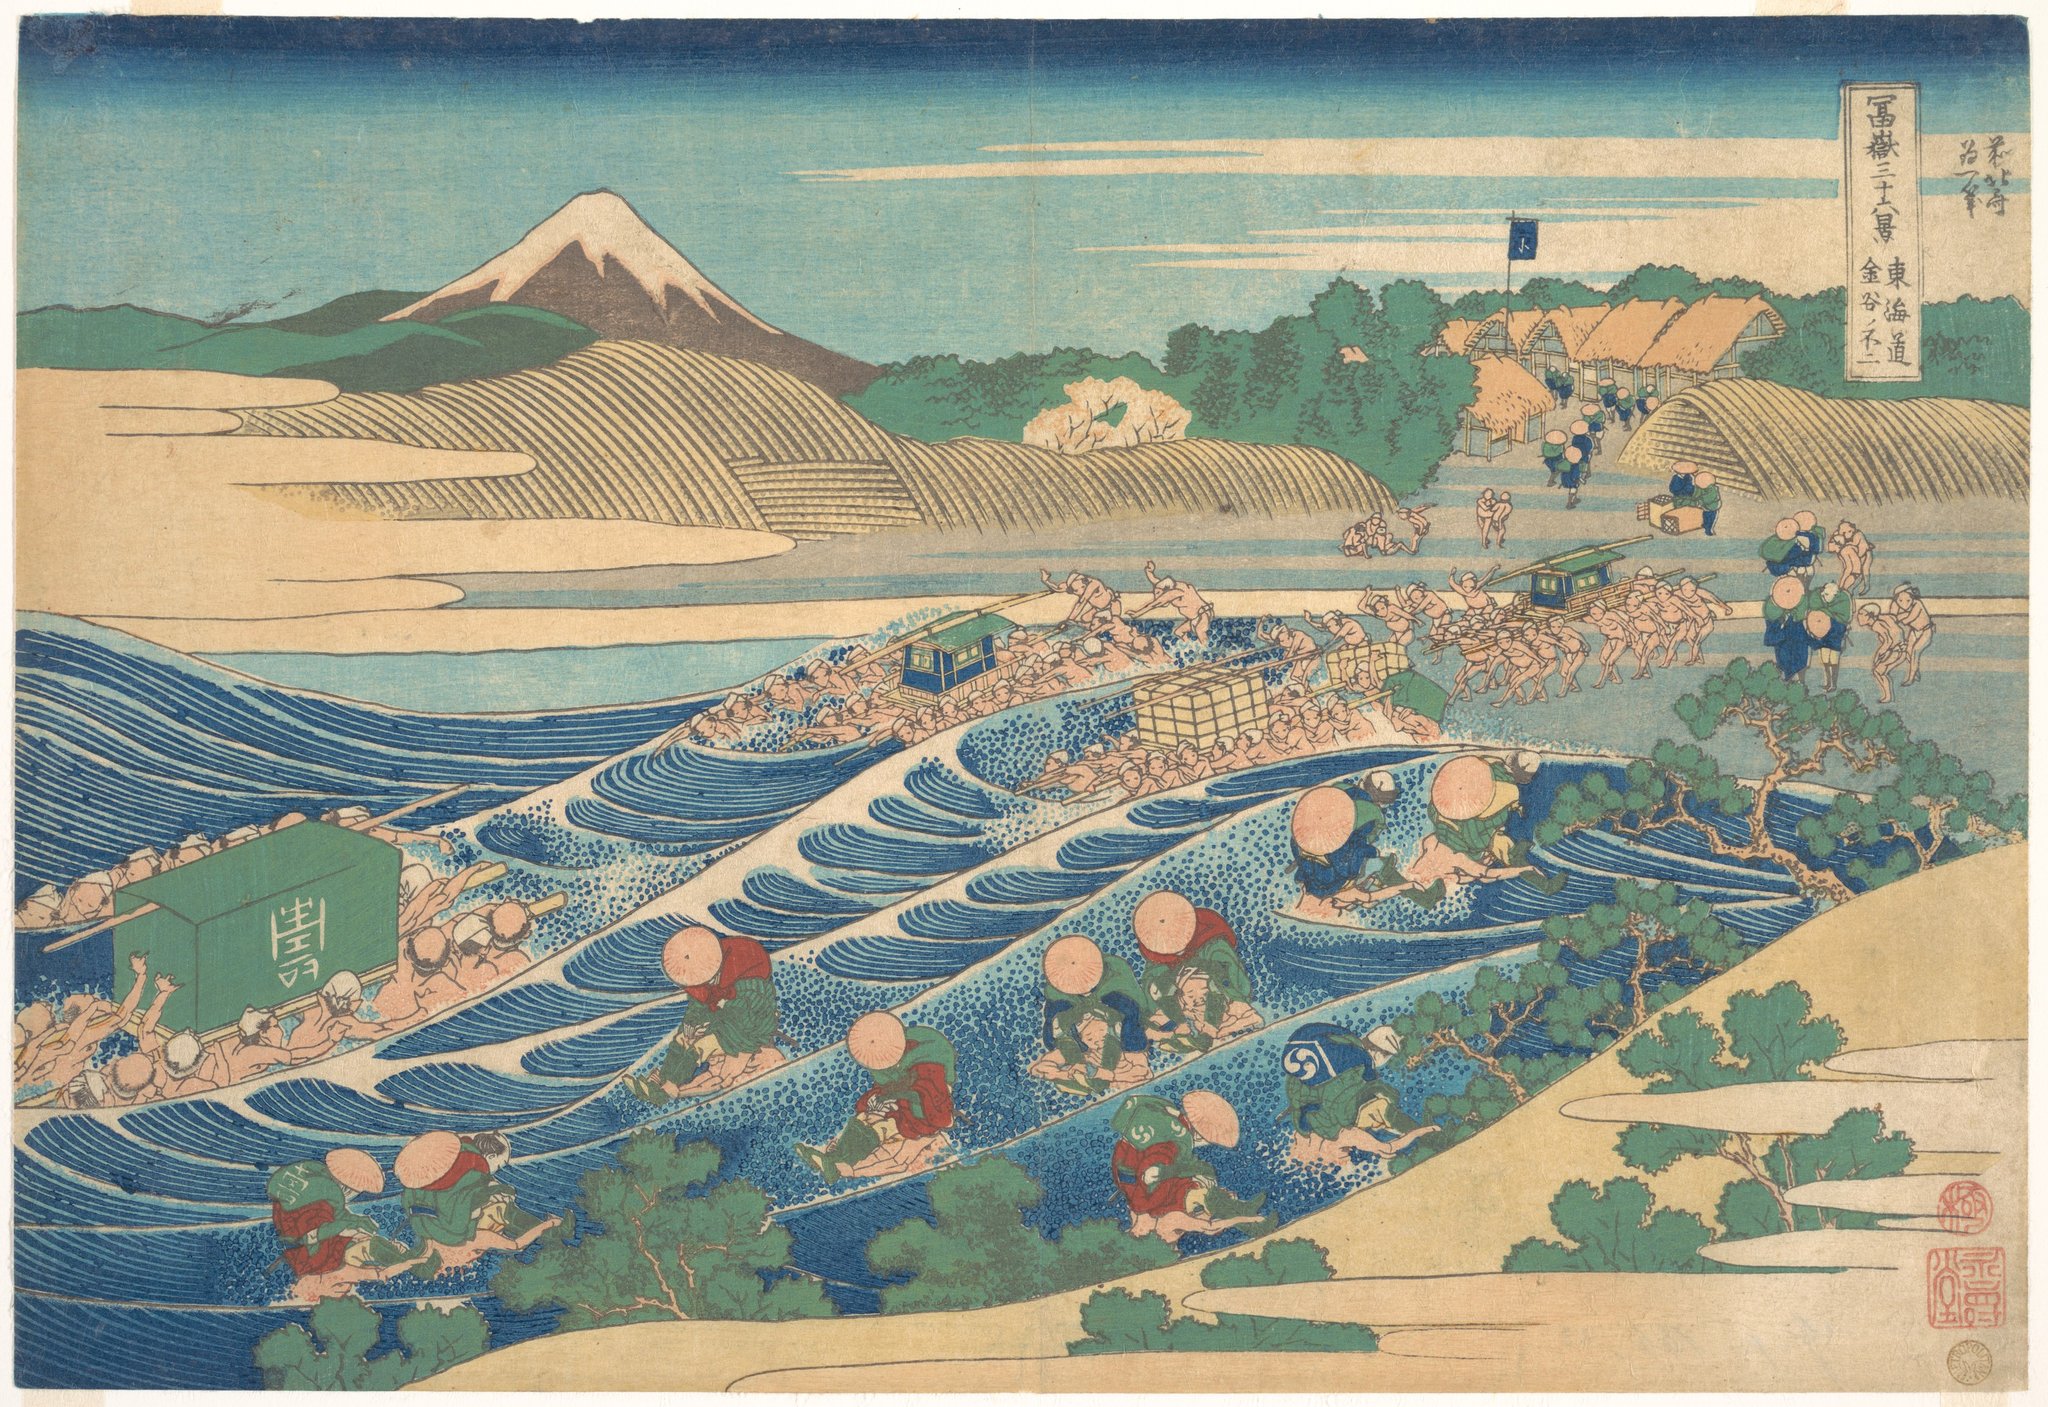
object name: woodblock print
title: Fuji Seen from Kanaya on the Tōkaidō (Tōkaidō Kanaya no Fuji), from the series Thirty-six Views of Mount Fuji (Fugaku sanjūrokkei)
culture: japanese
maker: katsushika hokusai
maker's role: artist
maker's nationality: japanese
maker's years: 1760-1849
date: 1830-1832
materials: ink, paper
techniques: woodblock print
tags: men,mountains,waves